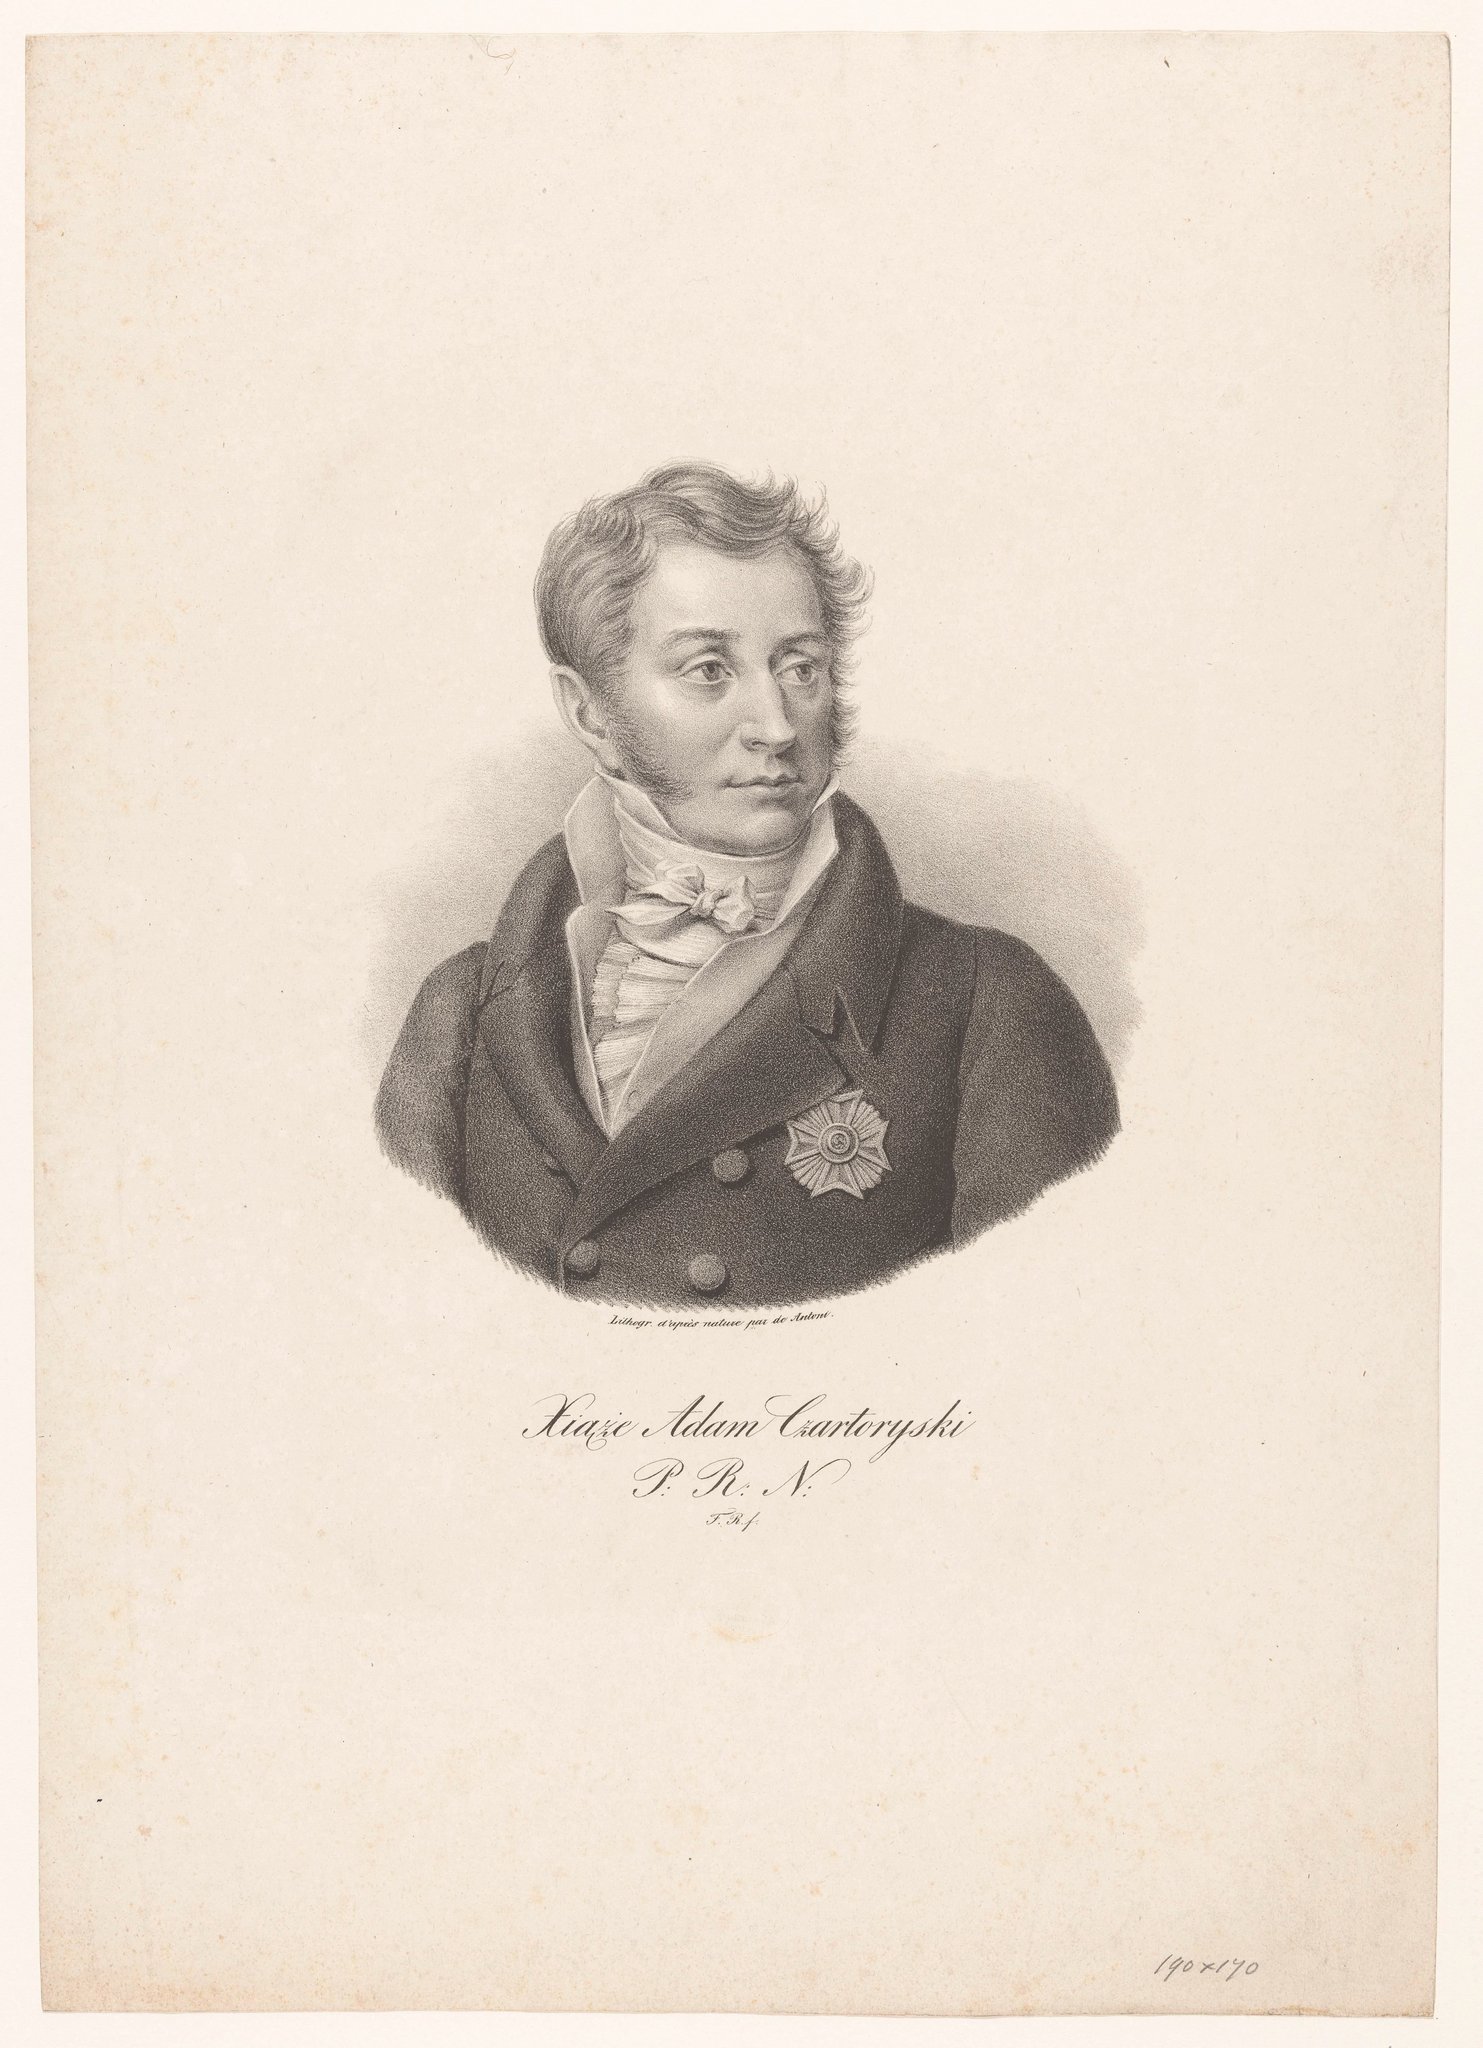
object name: print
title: Portret van de Poolse politicus Adam Jerzy Czartoryski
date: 1831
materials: paper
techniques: lithography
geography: warsaw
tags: adam jerzy czartoryski, historical persons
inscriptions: monogram: ‘F.R.f.’, collector's mark: Lugt 2228, check stamp: Lugt 3534